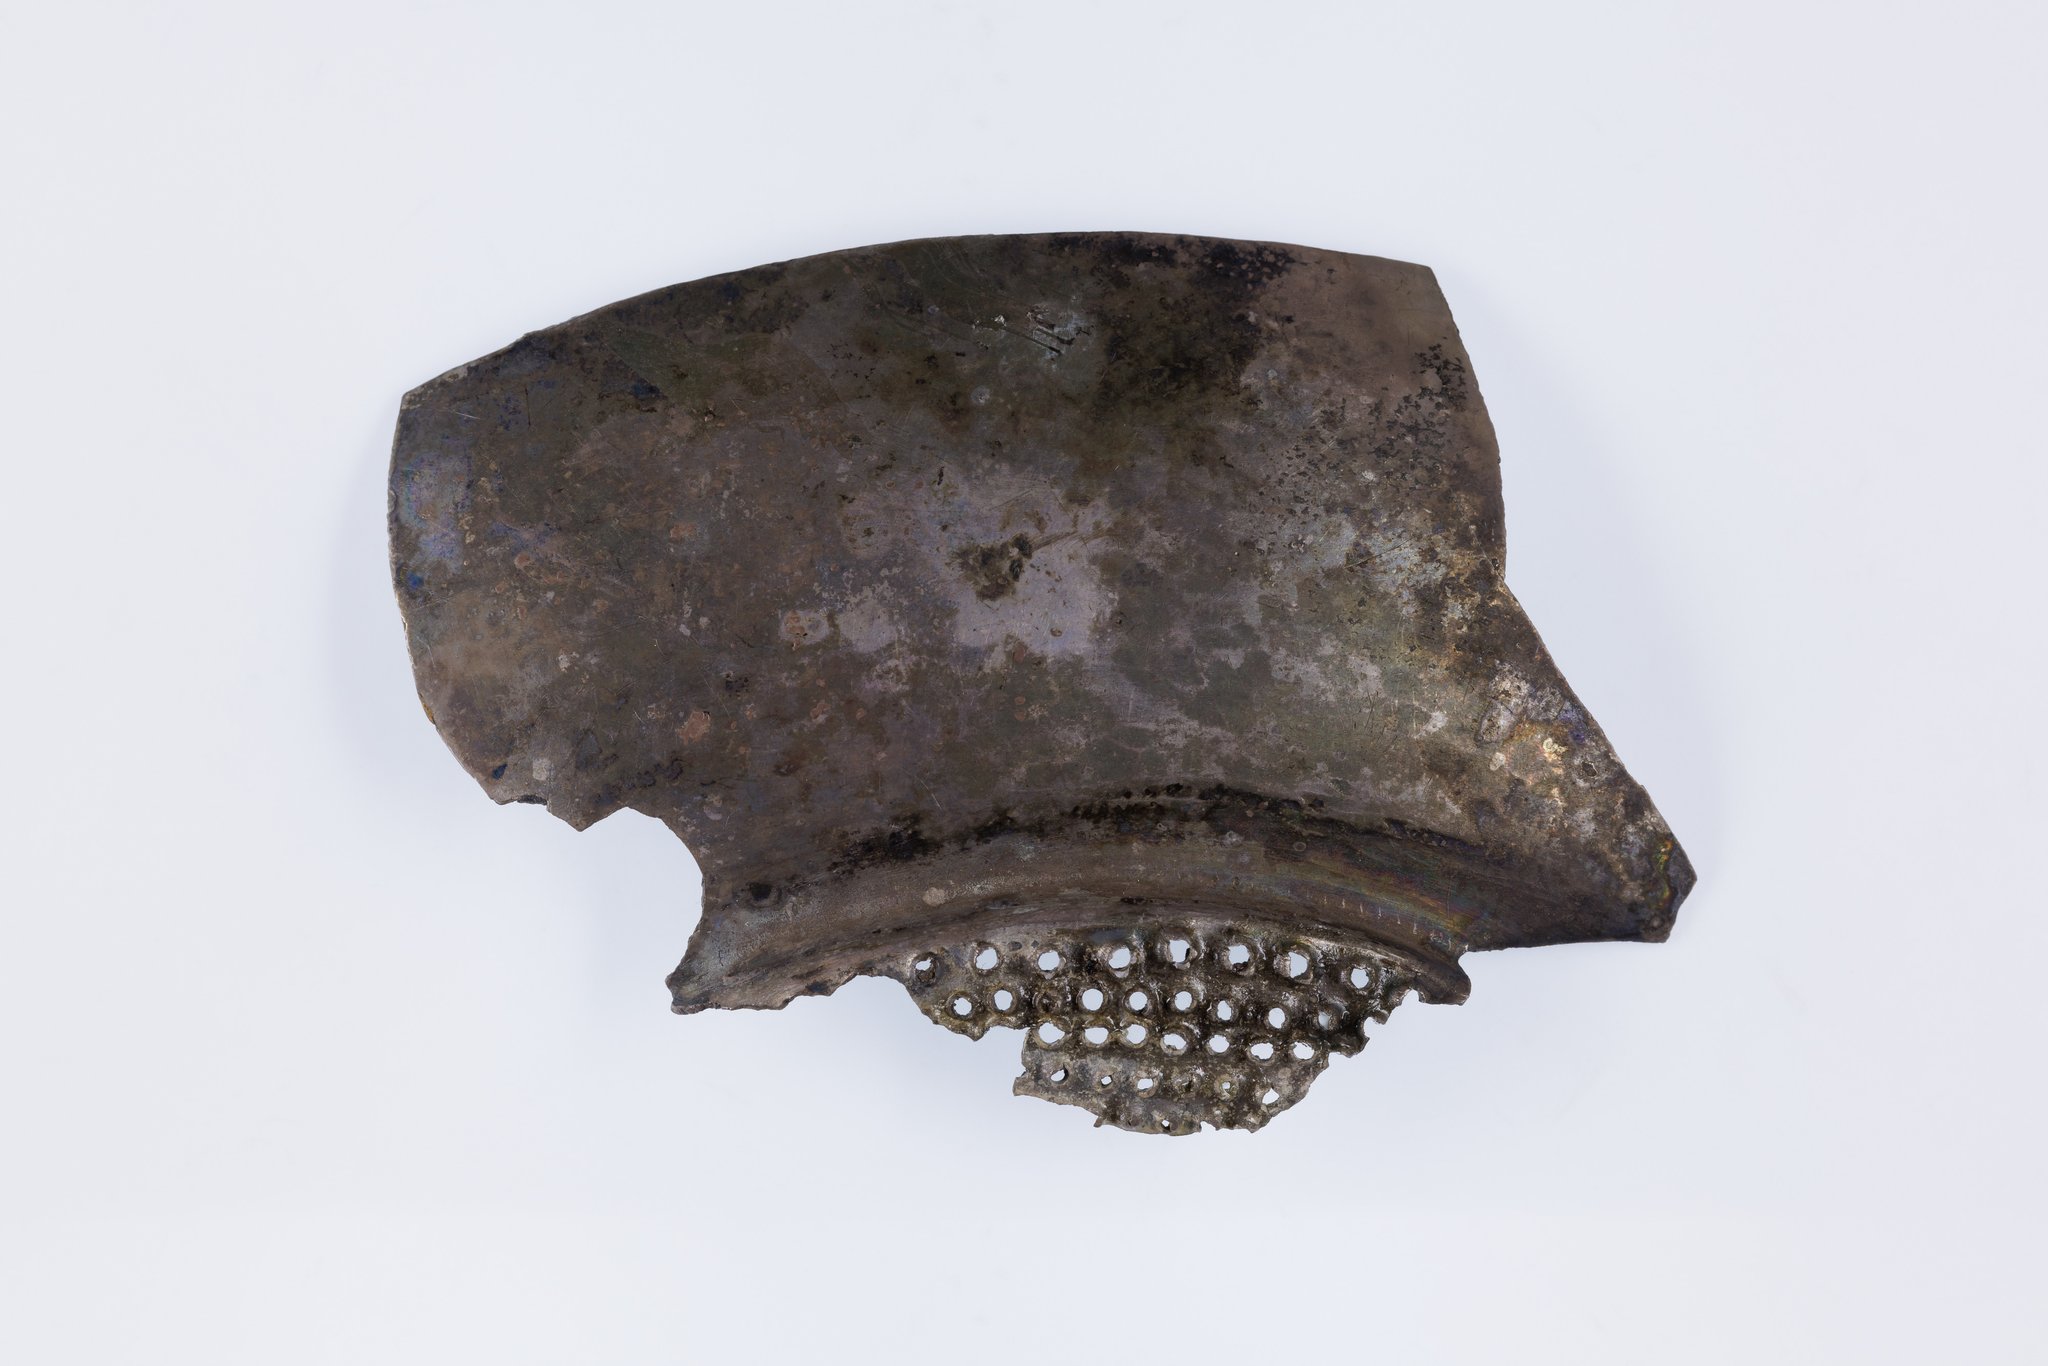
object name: strainer fragment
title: Fragment of a shallow strainer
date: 1295-1070 BCE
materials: silver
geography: egypt